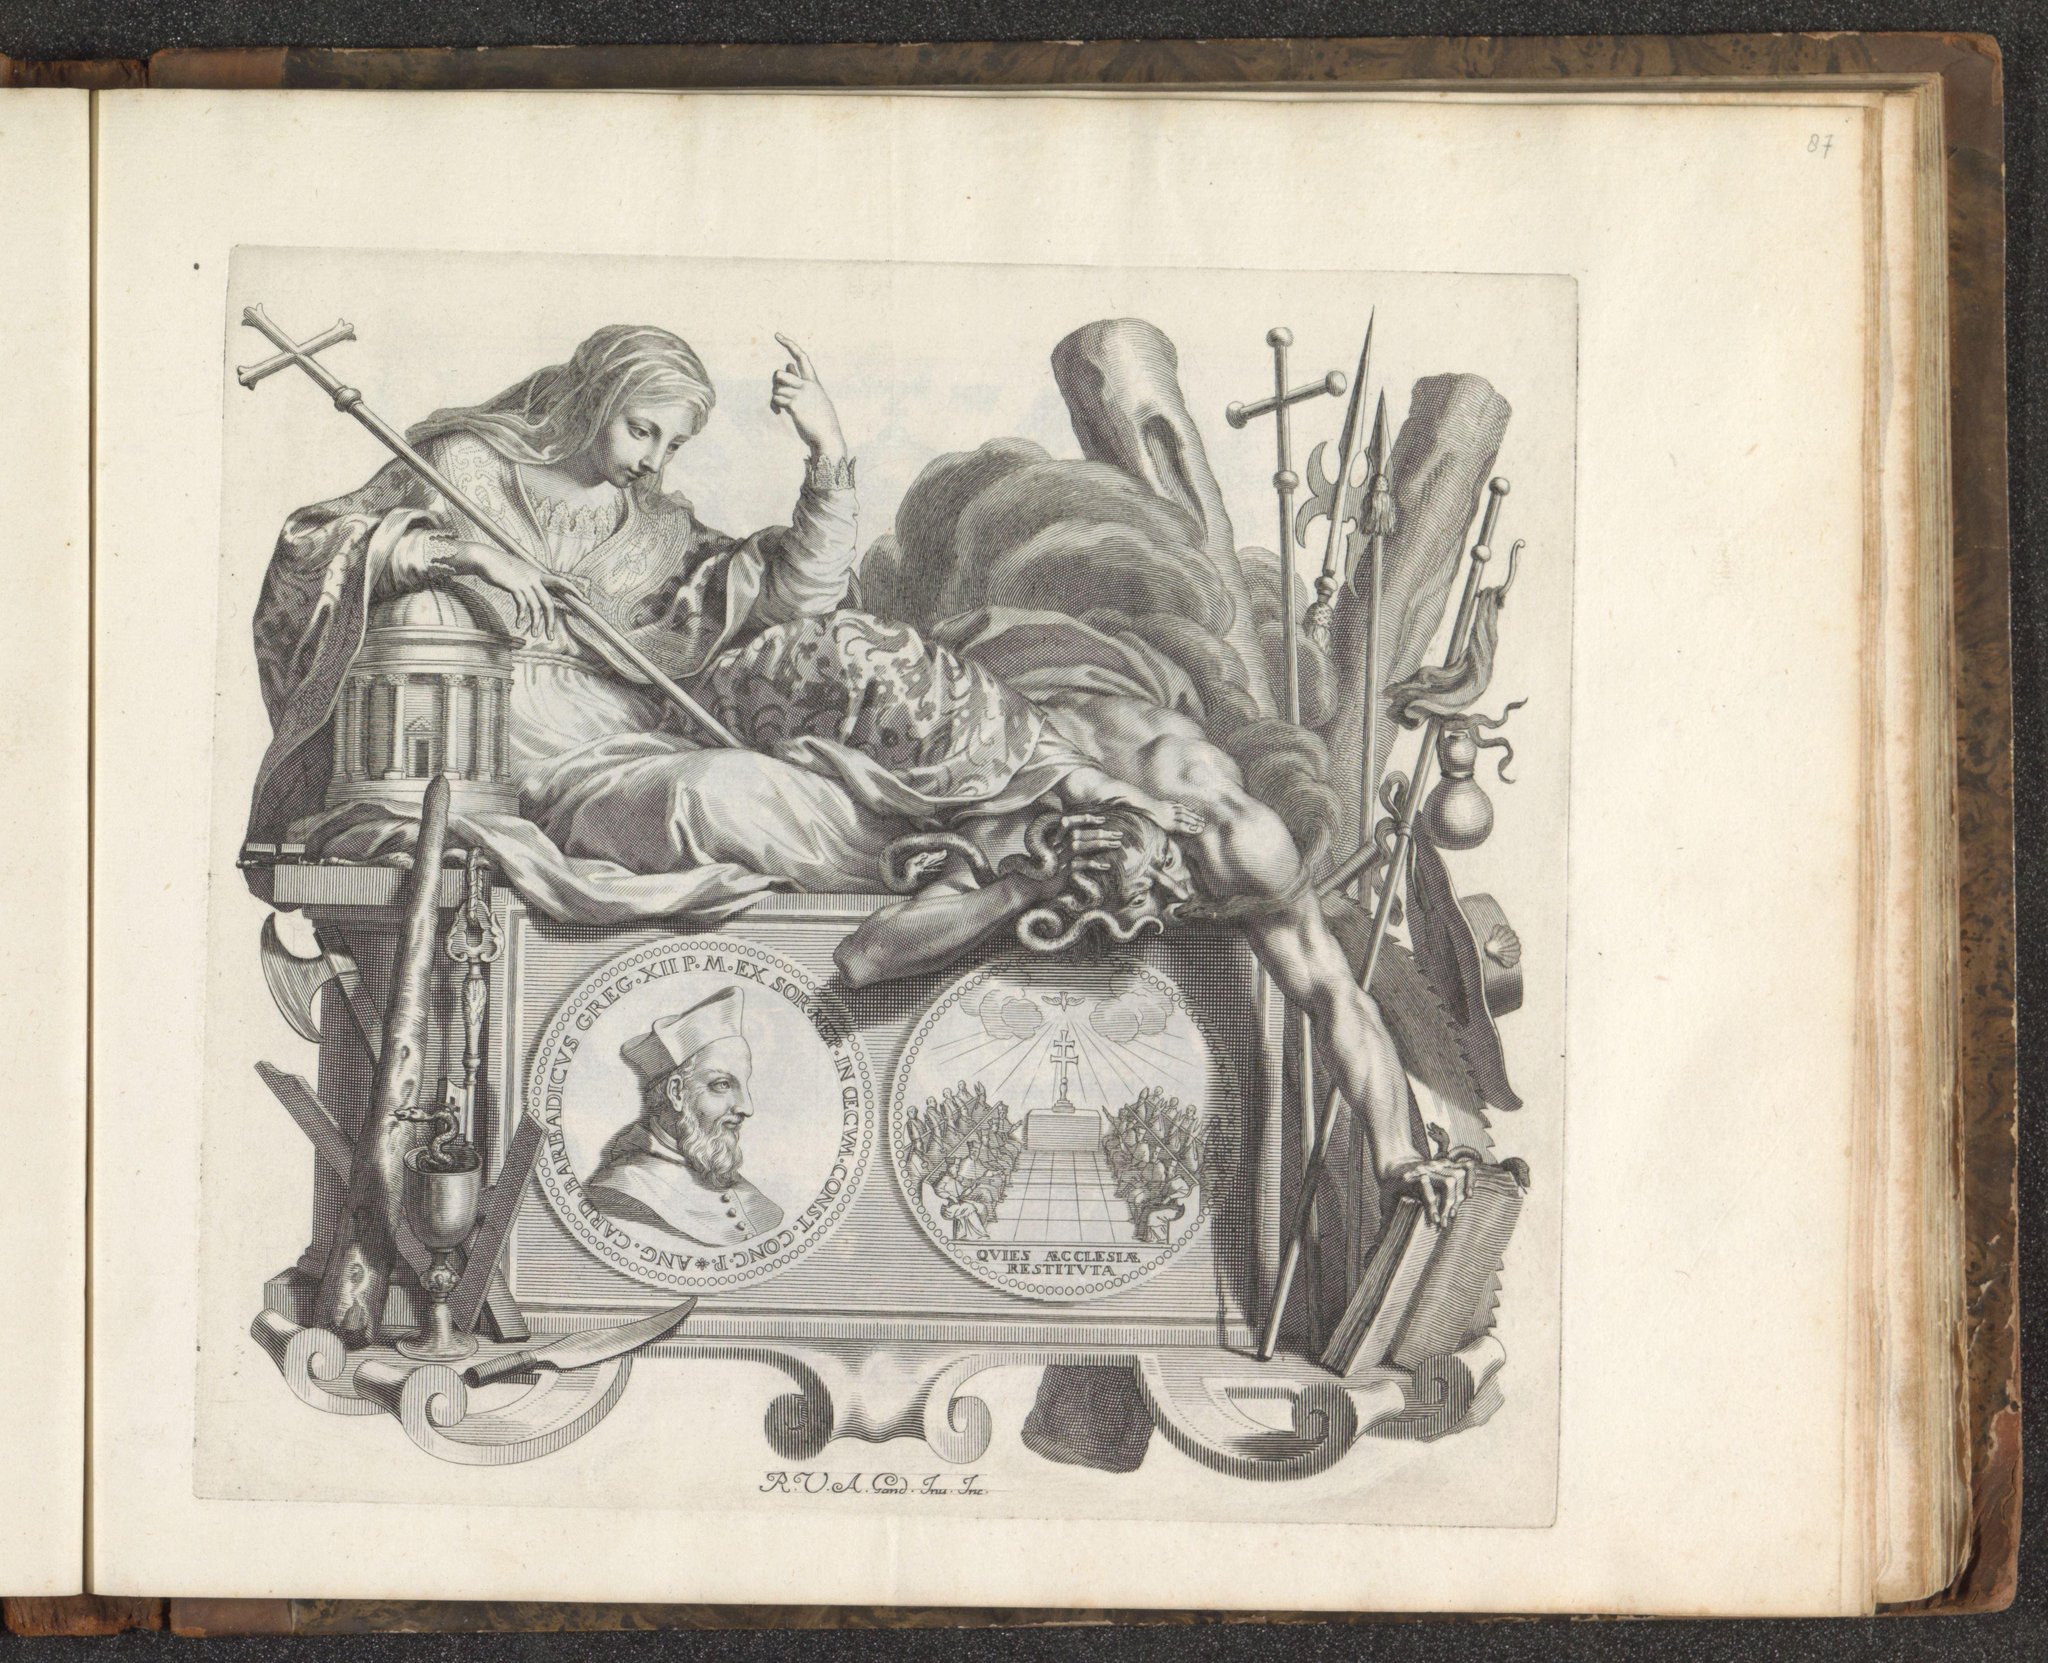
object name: album leaf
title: Portret van Angelo Barbarigo en de personificaties Religie en Ketterij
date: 1673-1743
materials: paper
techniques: engraving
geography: rome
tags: venice, heretic, medal (considered as a piece of sculpture, regardless of its specific function), allegorical representations ~ religion; 'religione', 'religione de ss. mauritio e lazaro', 'religione vera christiana' (ripa), vice, evil, sin; 'peccato' (ripa), pilgrim's dress and attributes, e.g. flask, hat, mantle, staff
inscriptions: collector's mark: Lugt 2228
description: Voetstuk in de vorm van een cartouche. Daarop een medaillon met op de voorkant het portret van Angelo Barbarigo. Hij draagt een biretta. Op de achterkant het Concilie van Konstanz. De deelnemers zitten aan weerszijden van een altaar met kruis. Daarboven de Heilige Geest in de vorm van een duif. Op het voetstuk verslaat Religie de personificatie van Ketterij. Religie is afgebeeld in een kerkelijk gewaad, een bisschopsstaf en een tempel. Ketterij is voorgesteld als een man met een slang. Uit zijn mond komt zwarte rook. Uit het boek bij zijn linkerhand kronkelt eveneens een slang. Links onderaan een sleutel, knots, gifbeker, bijl en mes. Links staat onder andere een pelgrimsstaf. De prent maakt deel uit van een album.